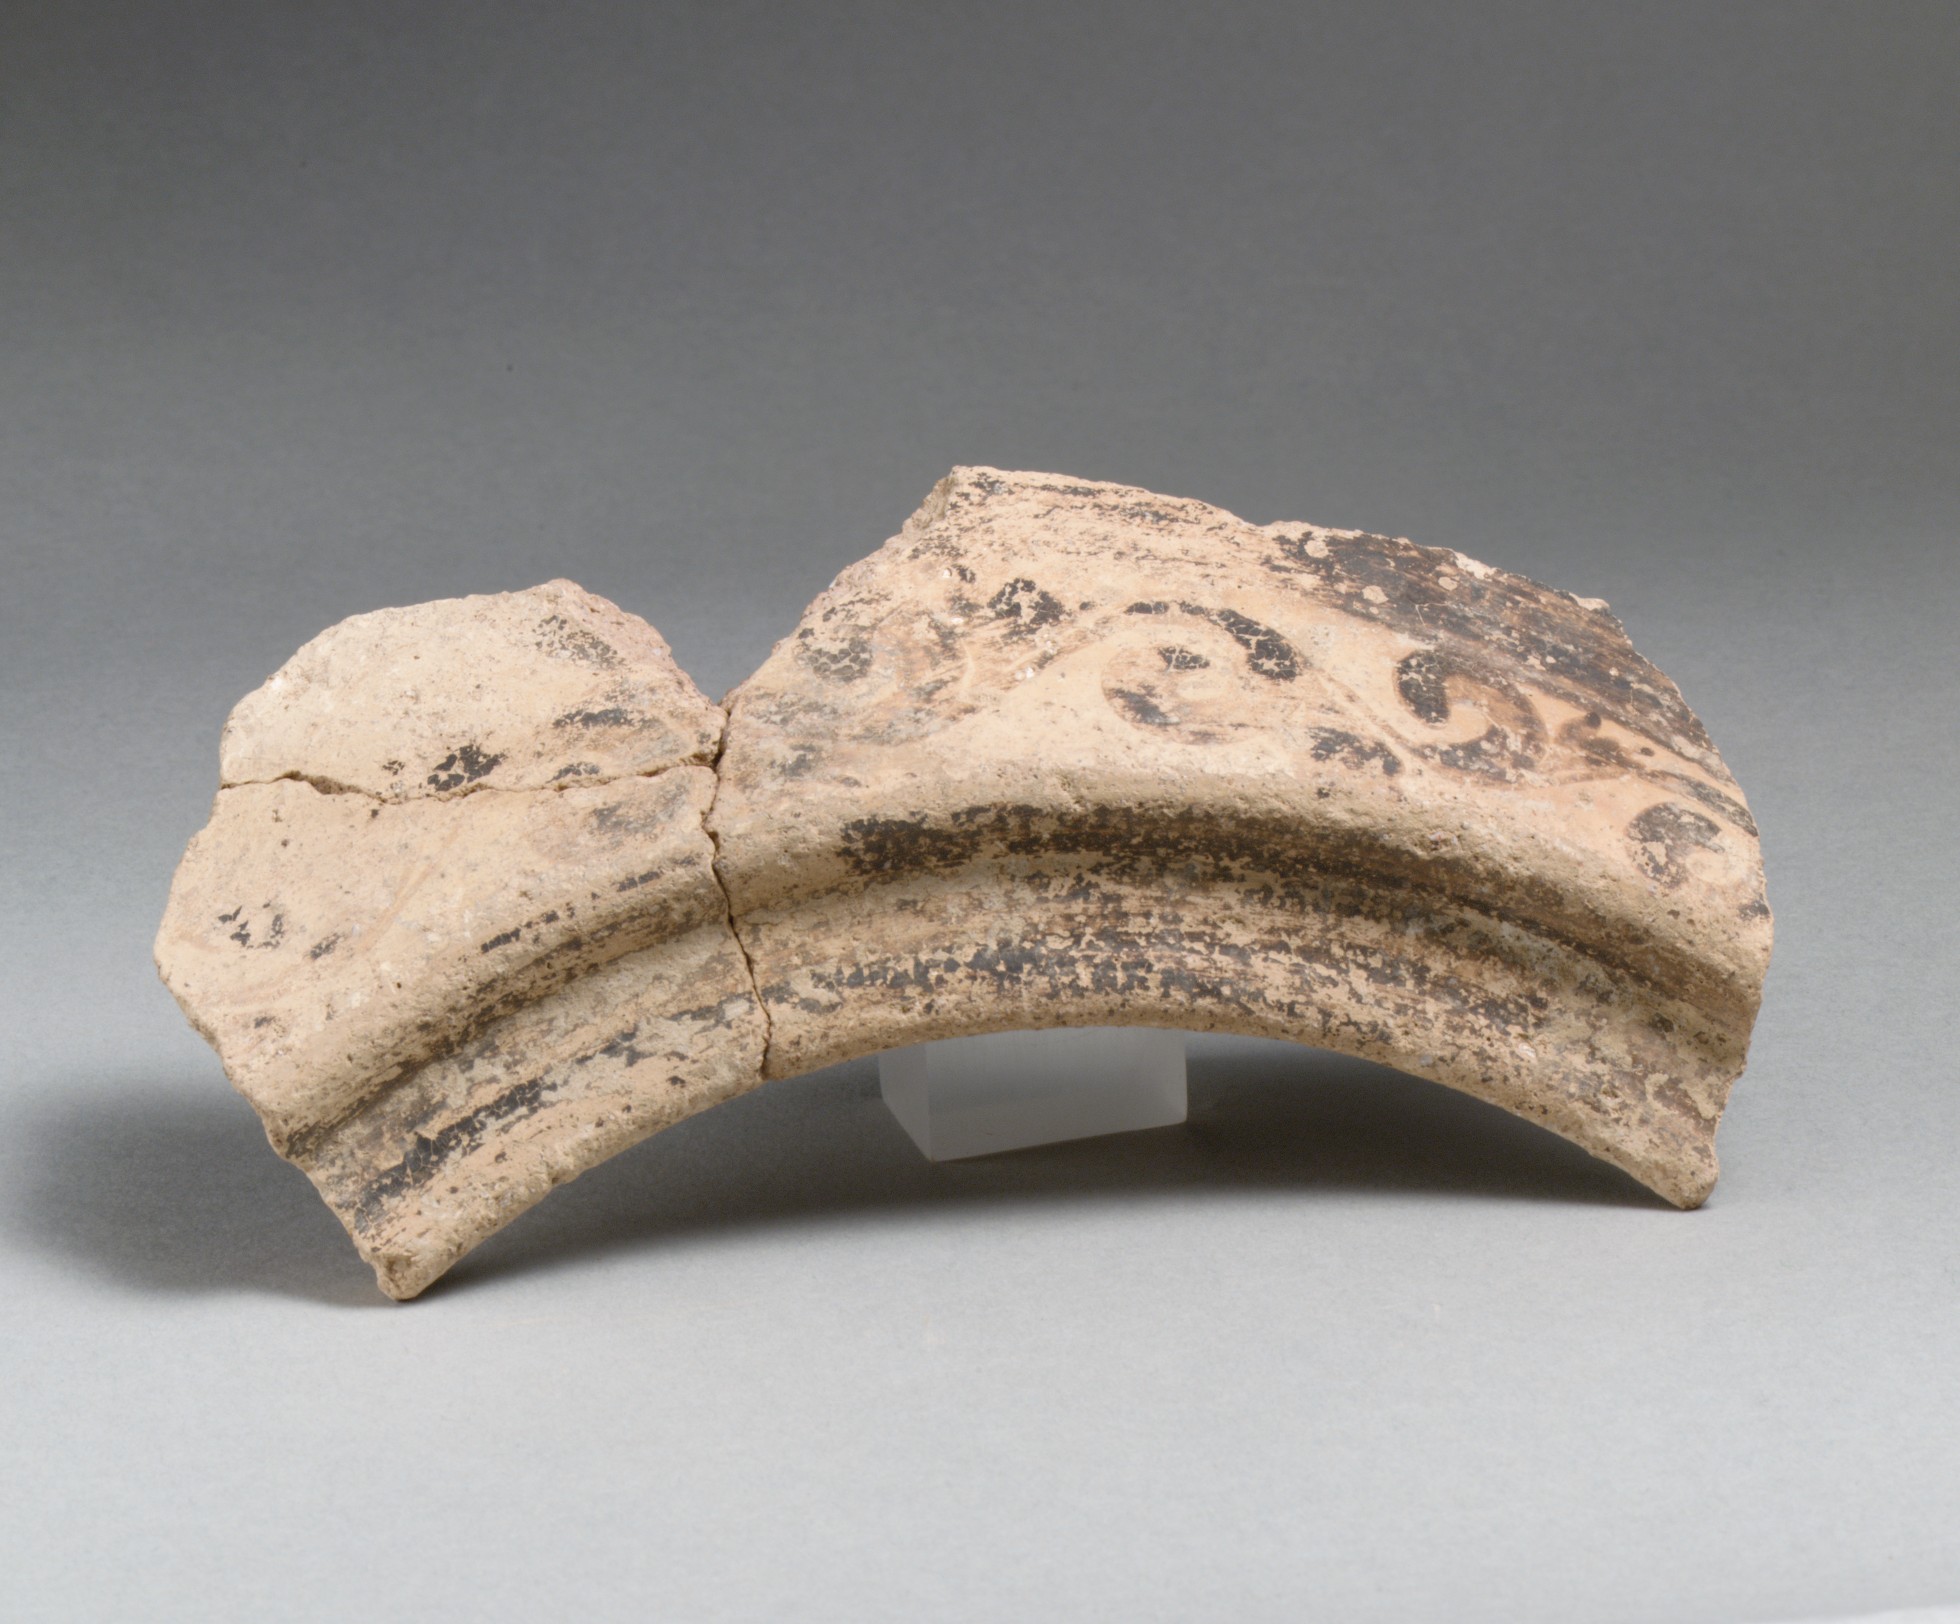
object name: vase fragment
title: Vase fragments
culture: minoan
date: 1600-1450 BCE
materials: terracotta